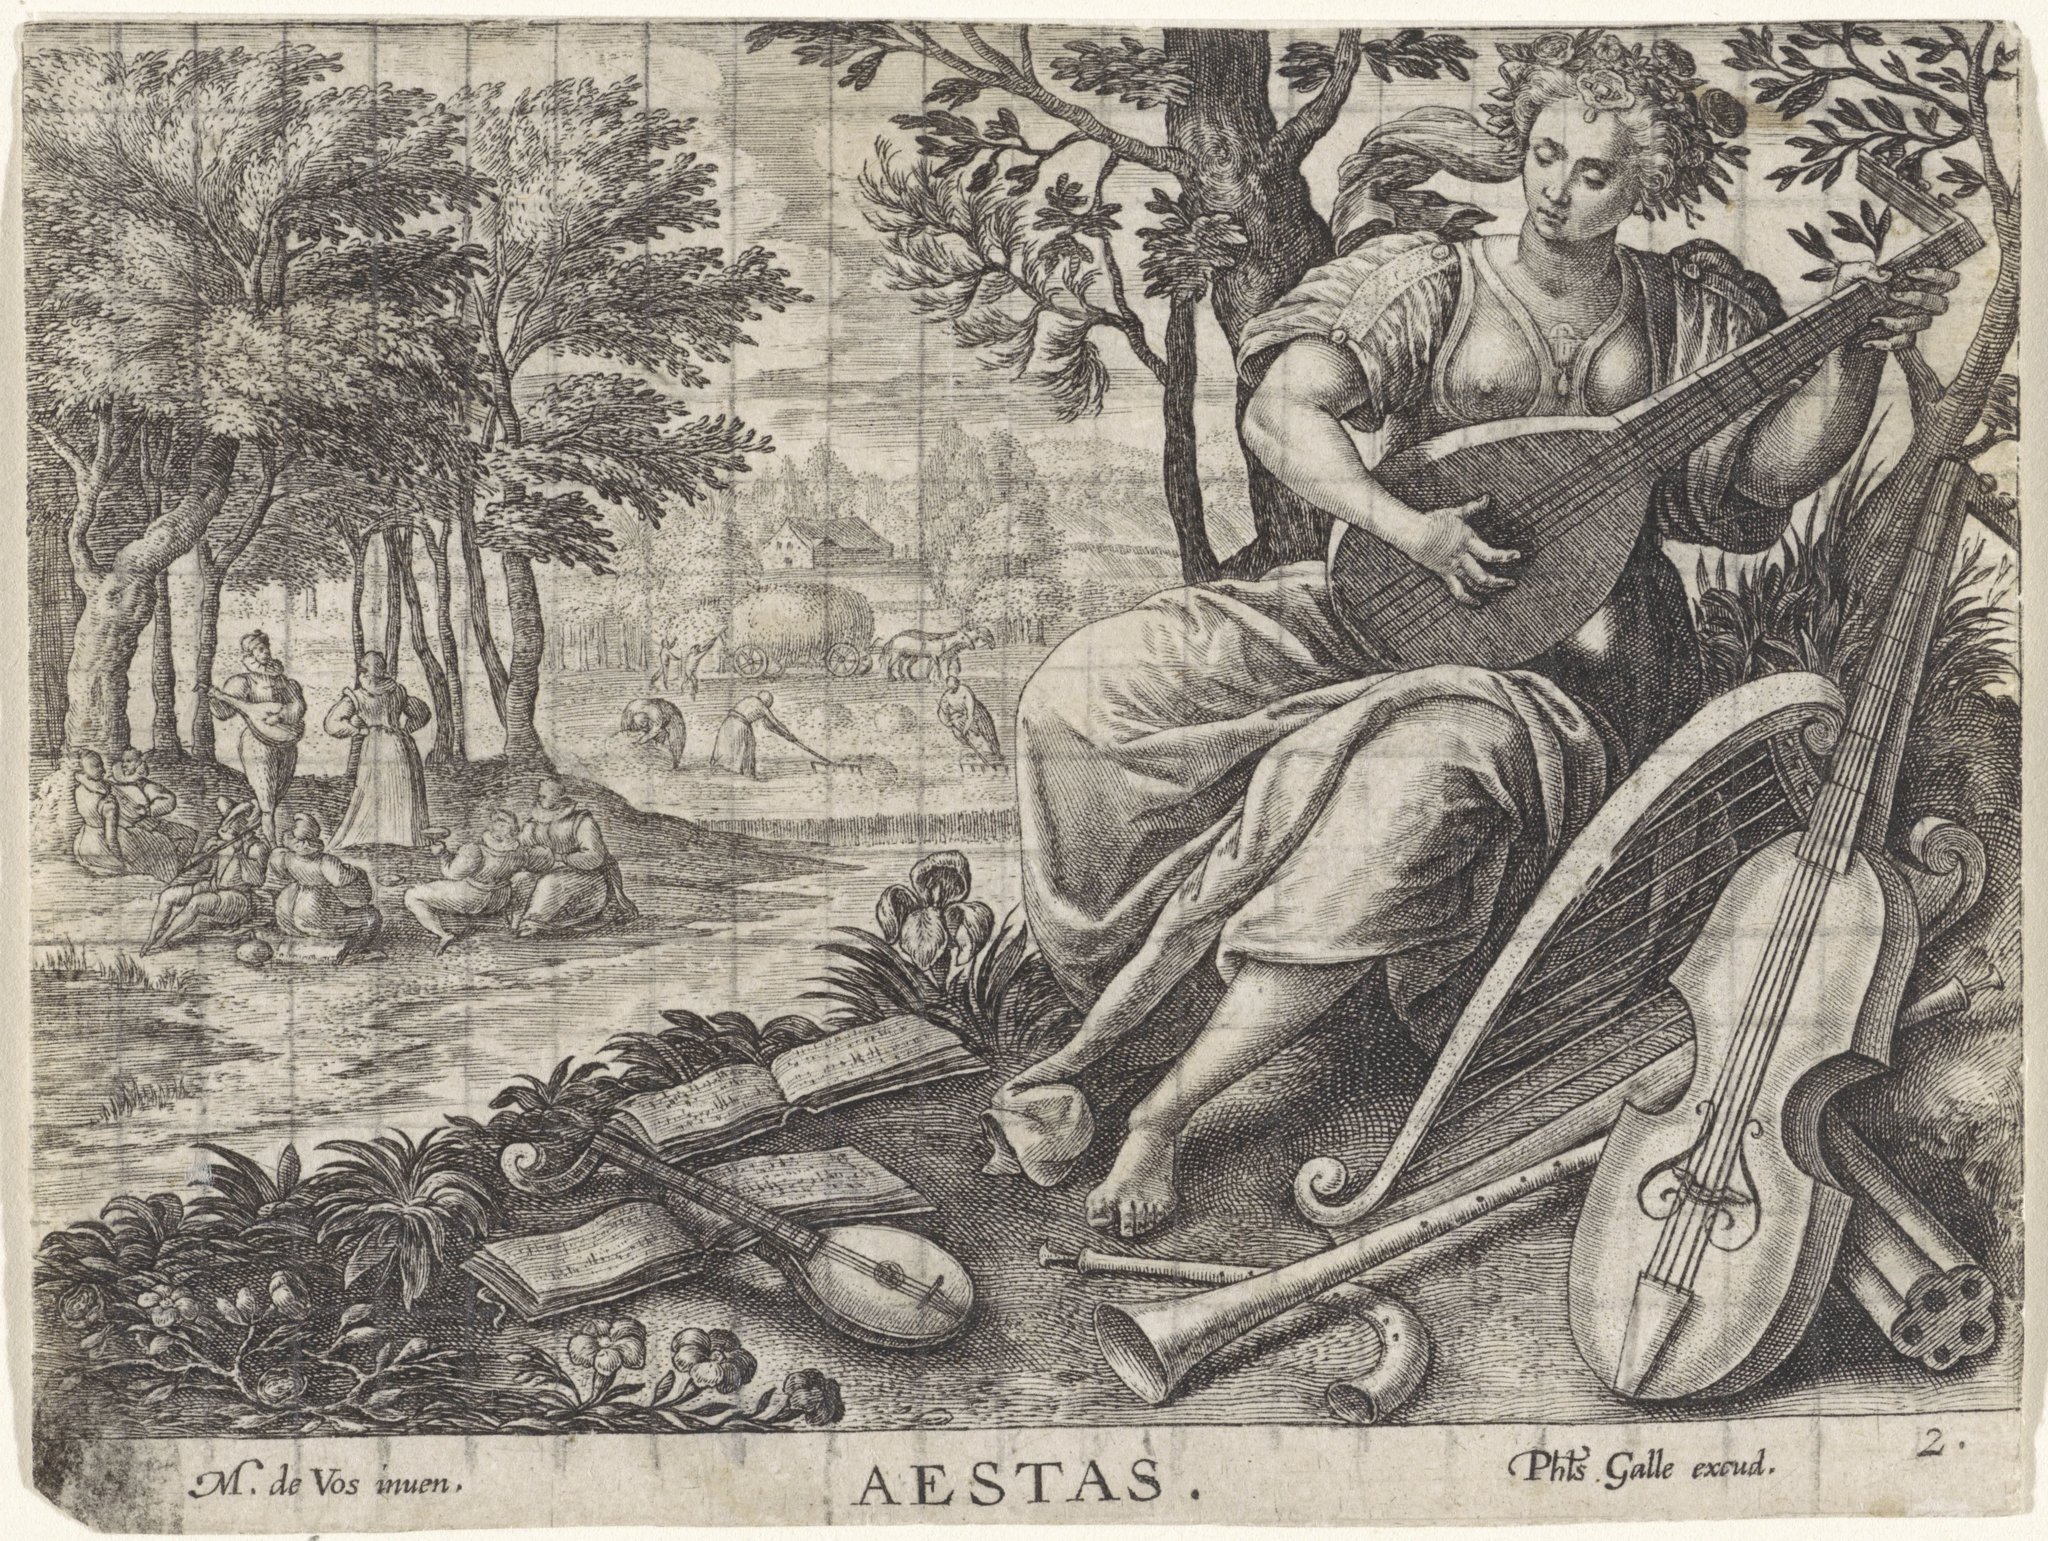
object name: print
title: Zomer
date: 1570-1612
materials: paper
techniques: engraving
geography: antwerp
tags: instrumental and vocal music together - cc - out of doors, musical instruments; group of musical instruments - cc - out of doors, agricultural products and by-products: hay (+ harvesting ~ agricultural processes), summer ~ human activities (the four seasons of the year)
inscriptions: collector's mark: Lugt 2760, collector's mark: Lugt 2228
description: Rechts bespeelt de personificatie van de Zomer een luit. Bij haar ligt bladmuziek en verschillende muziekinstrumenten. Linksachter een musicerend en drinkend gezelschap in de buitenlucht. In de verte wordt hooi geoogst.